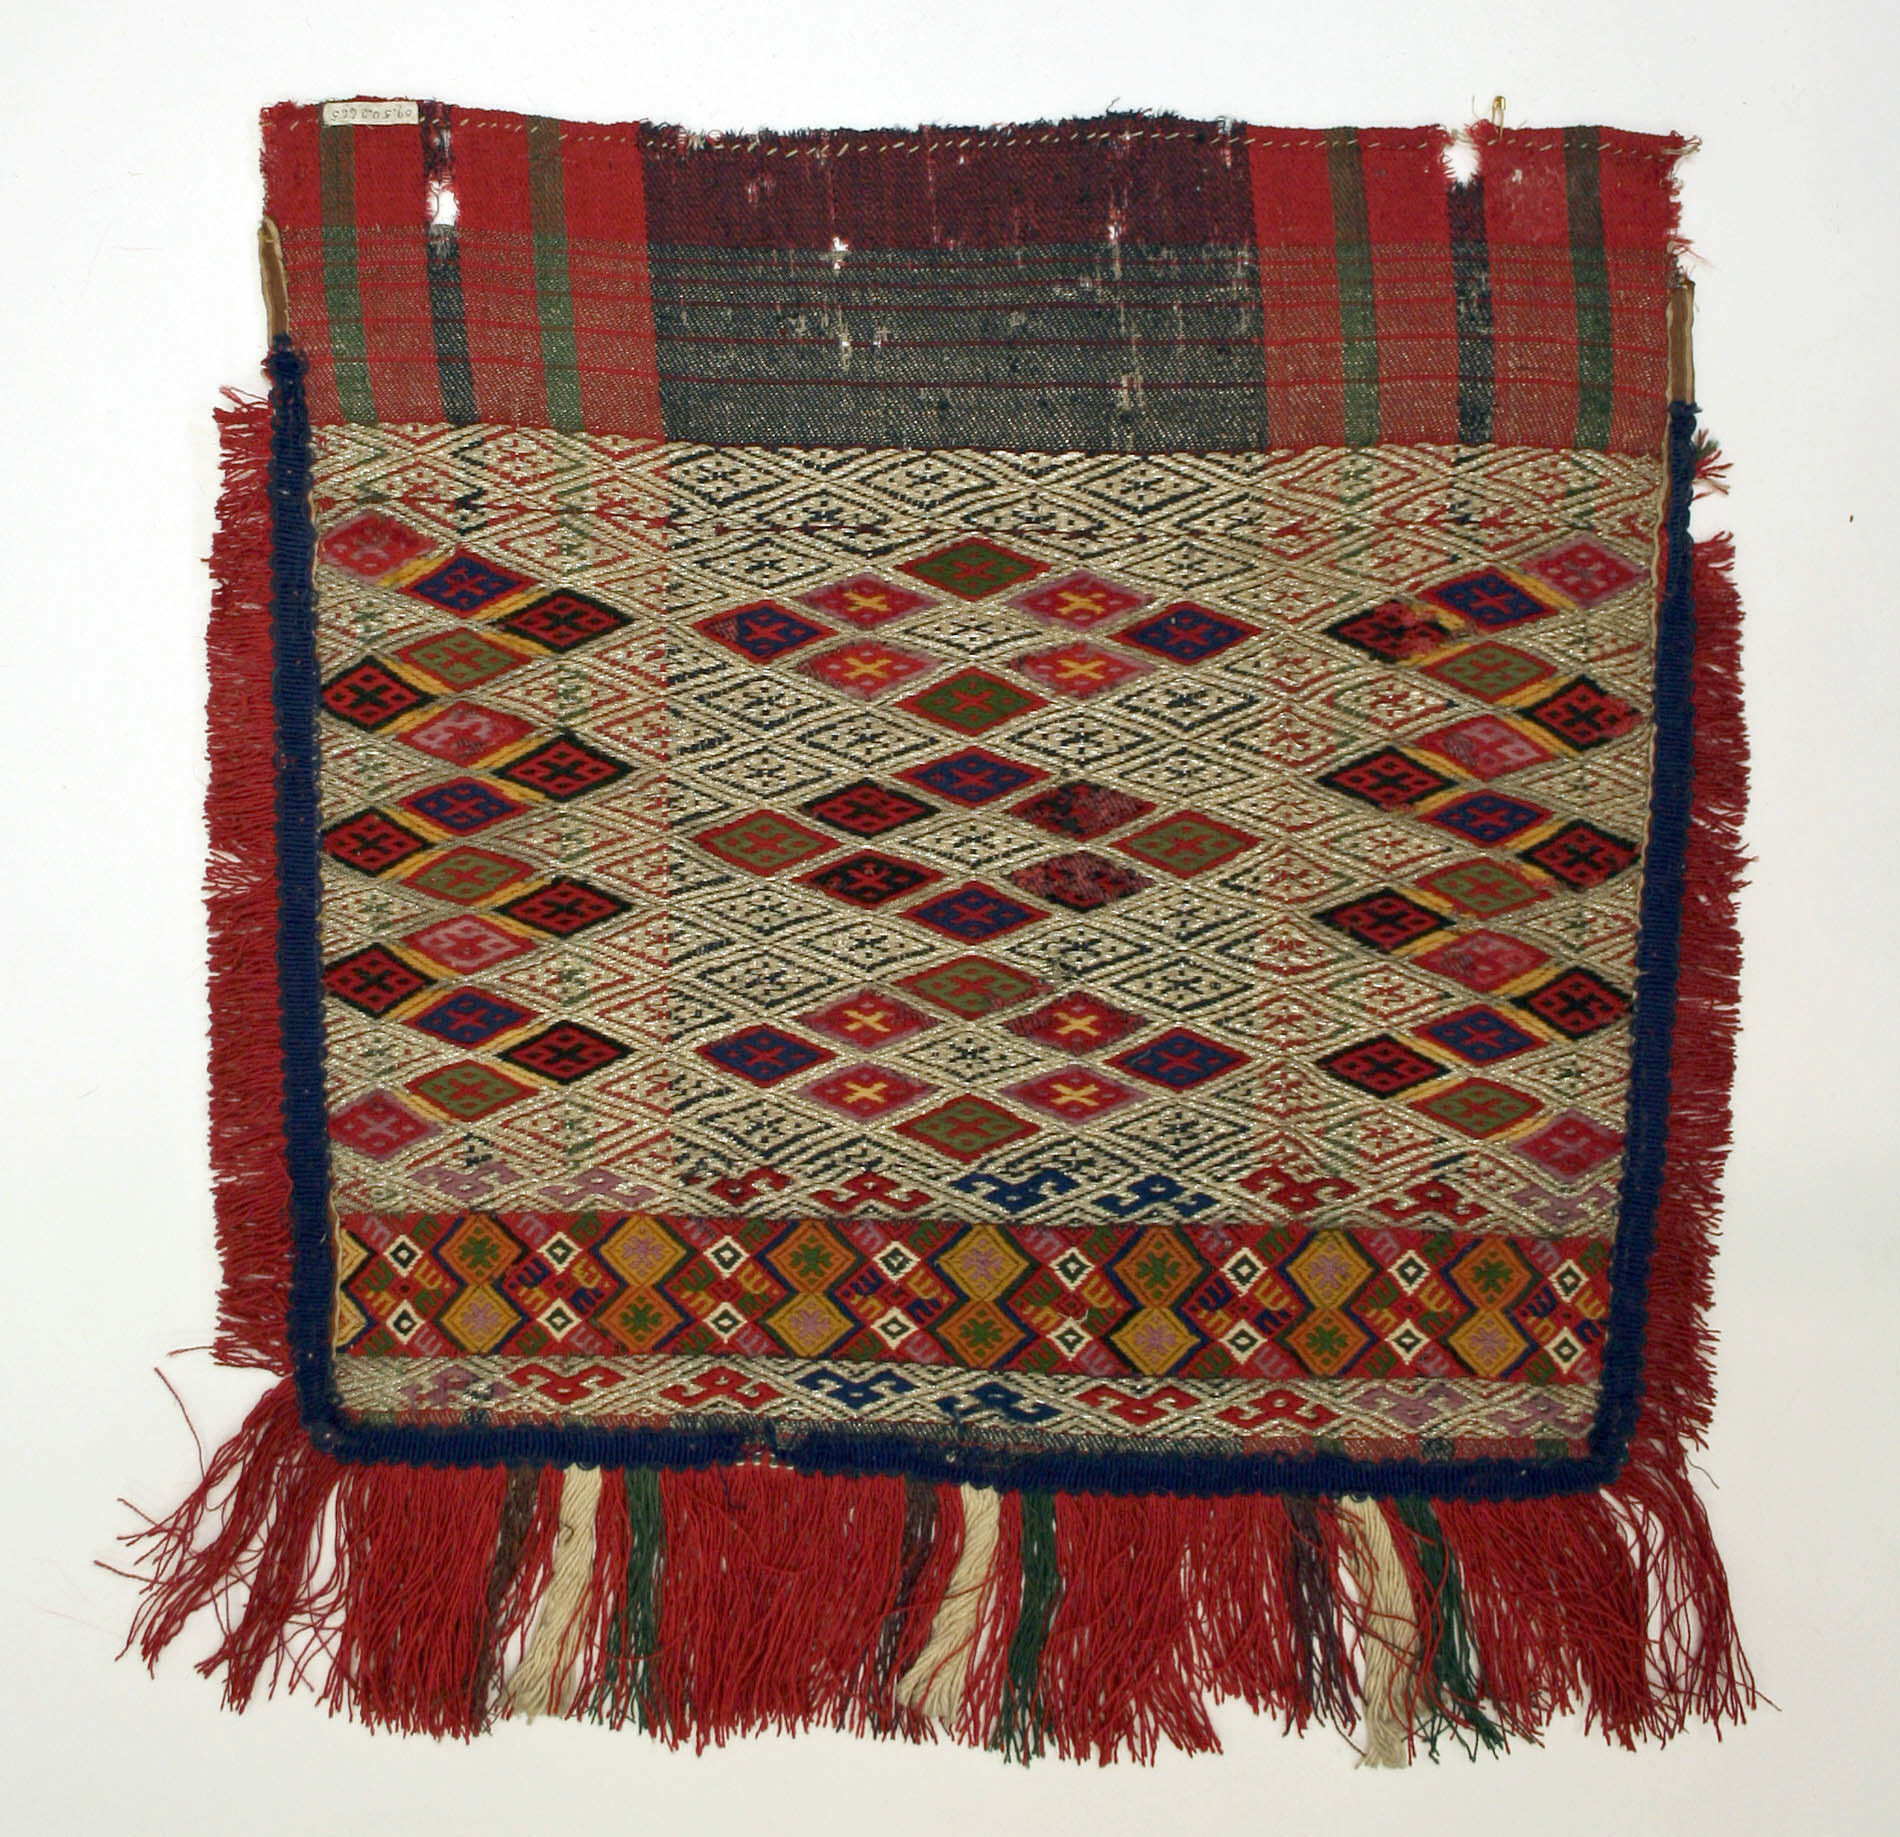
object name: apron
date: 1801-1900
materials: wool